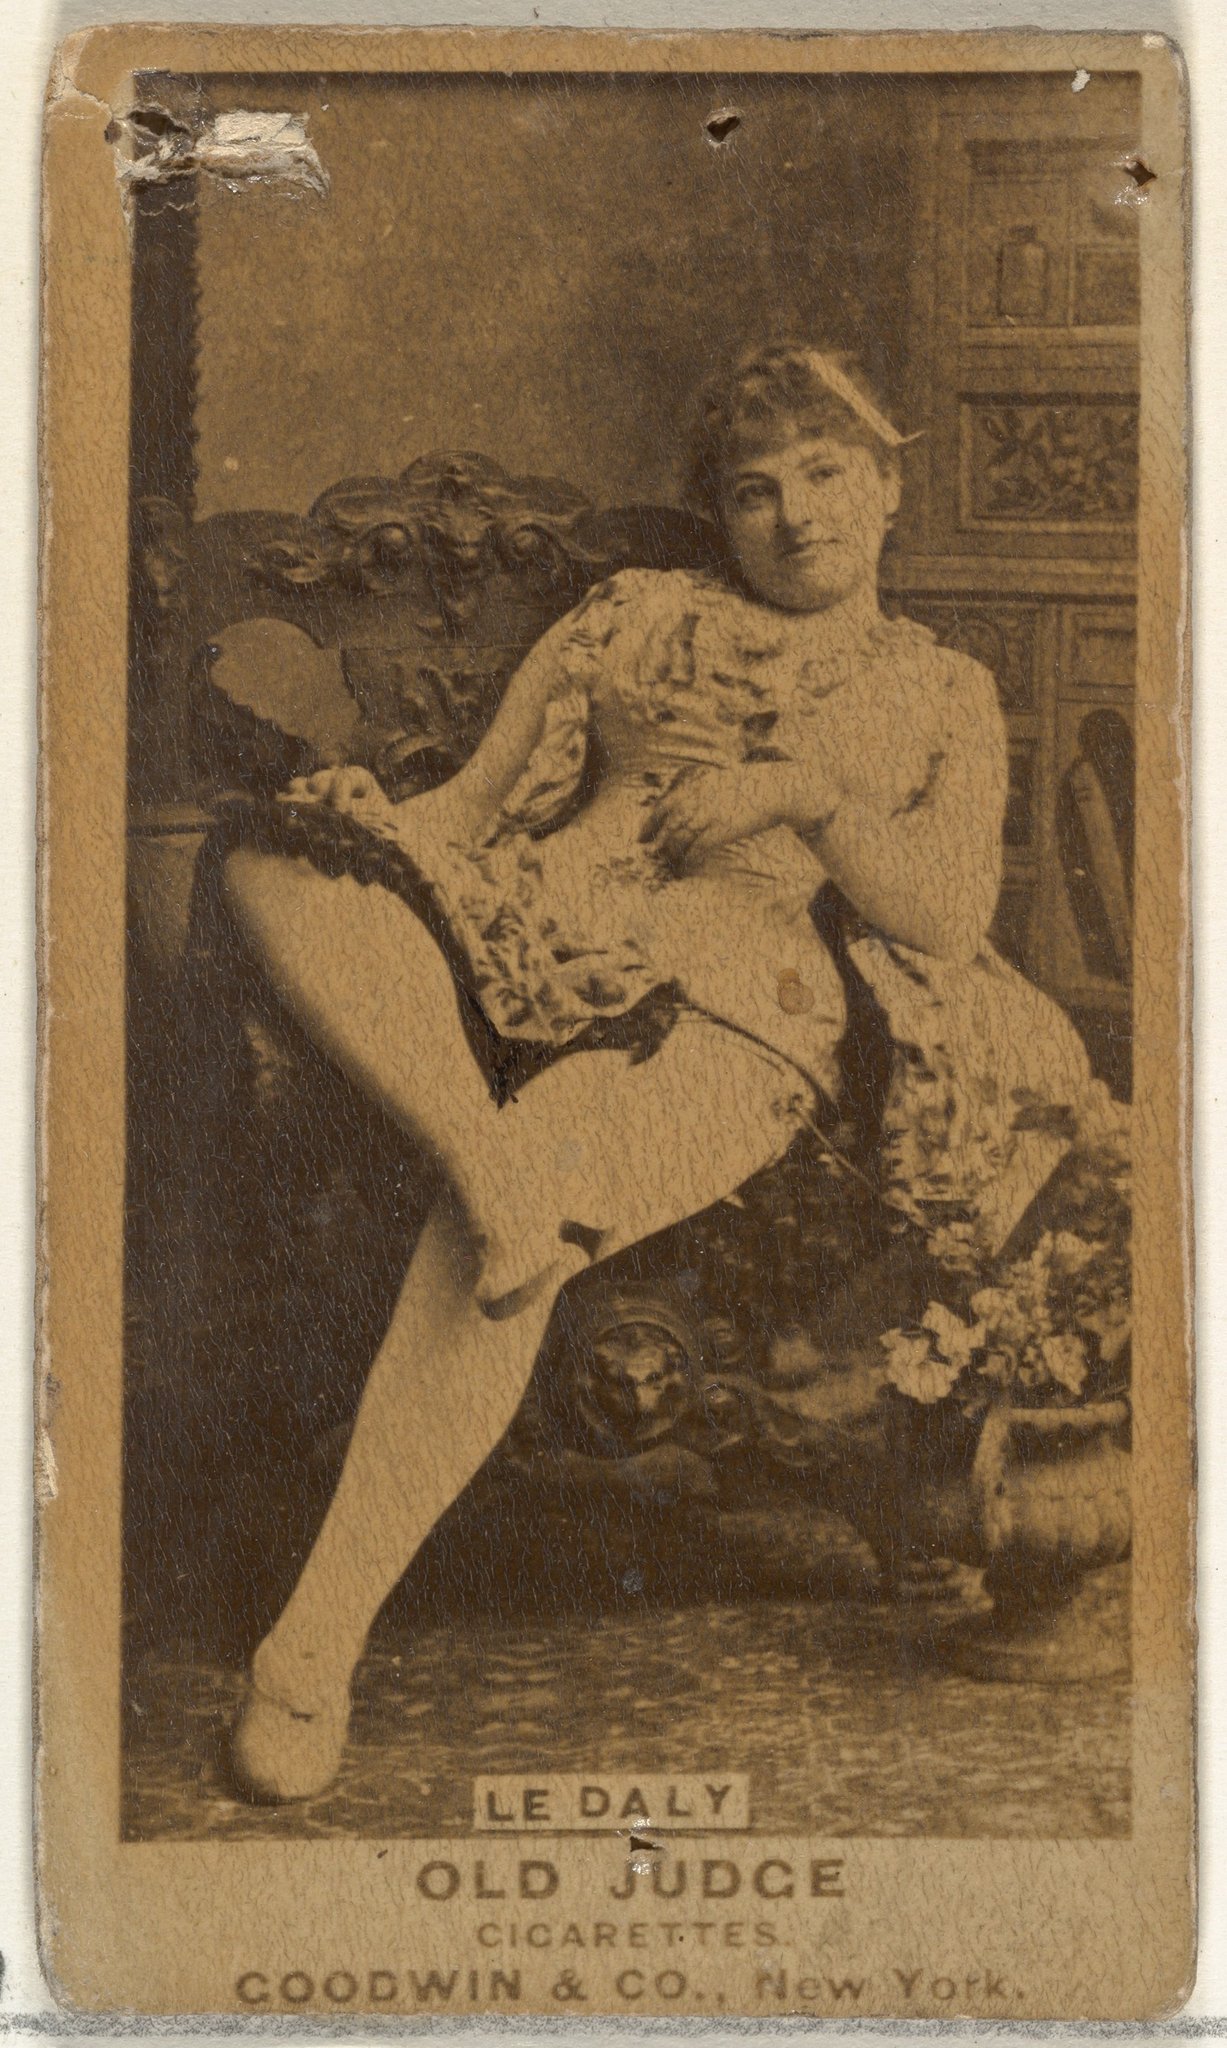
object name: photograph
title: Le Daly, from the Actors and Actresses series (N171) for Old Judge Cigarettes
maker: goodwin & company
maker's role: publisher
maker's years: 1850-1950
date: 1886-1890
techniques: albumen silver print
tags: portraits,women,actresses